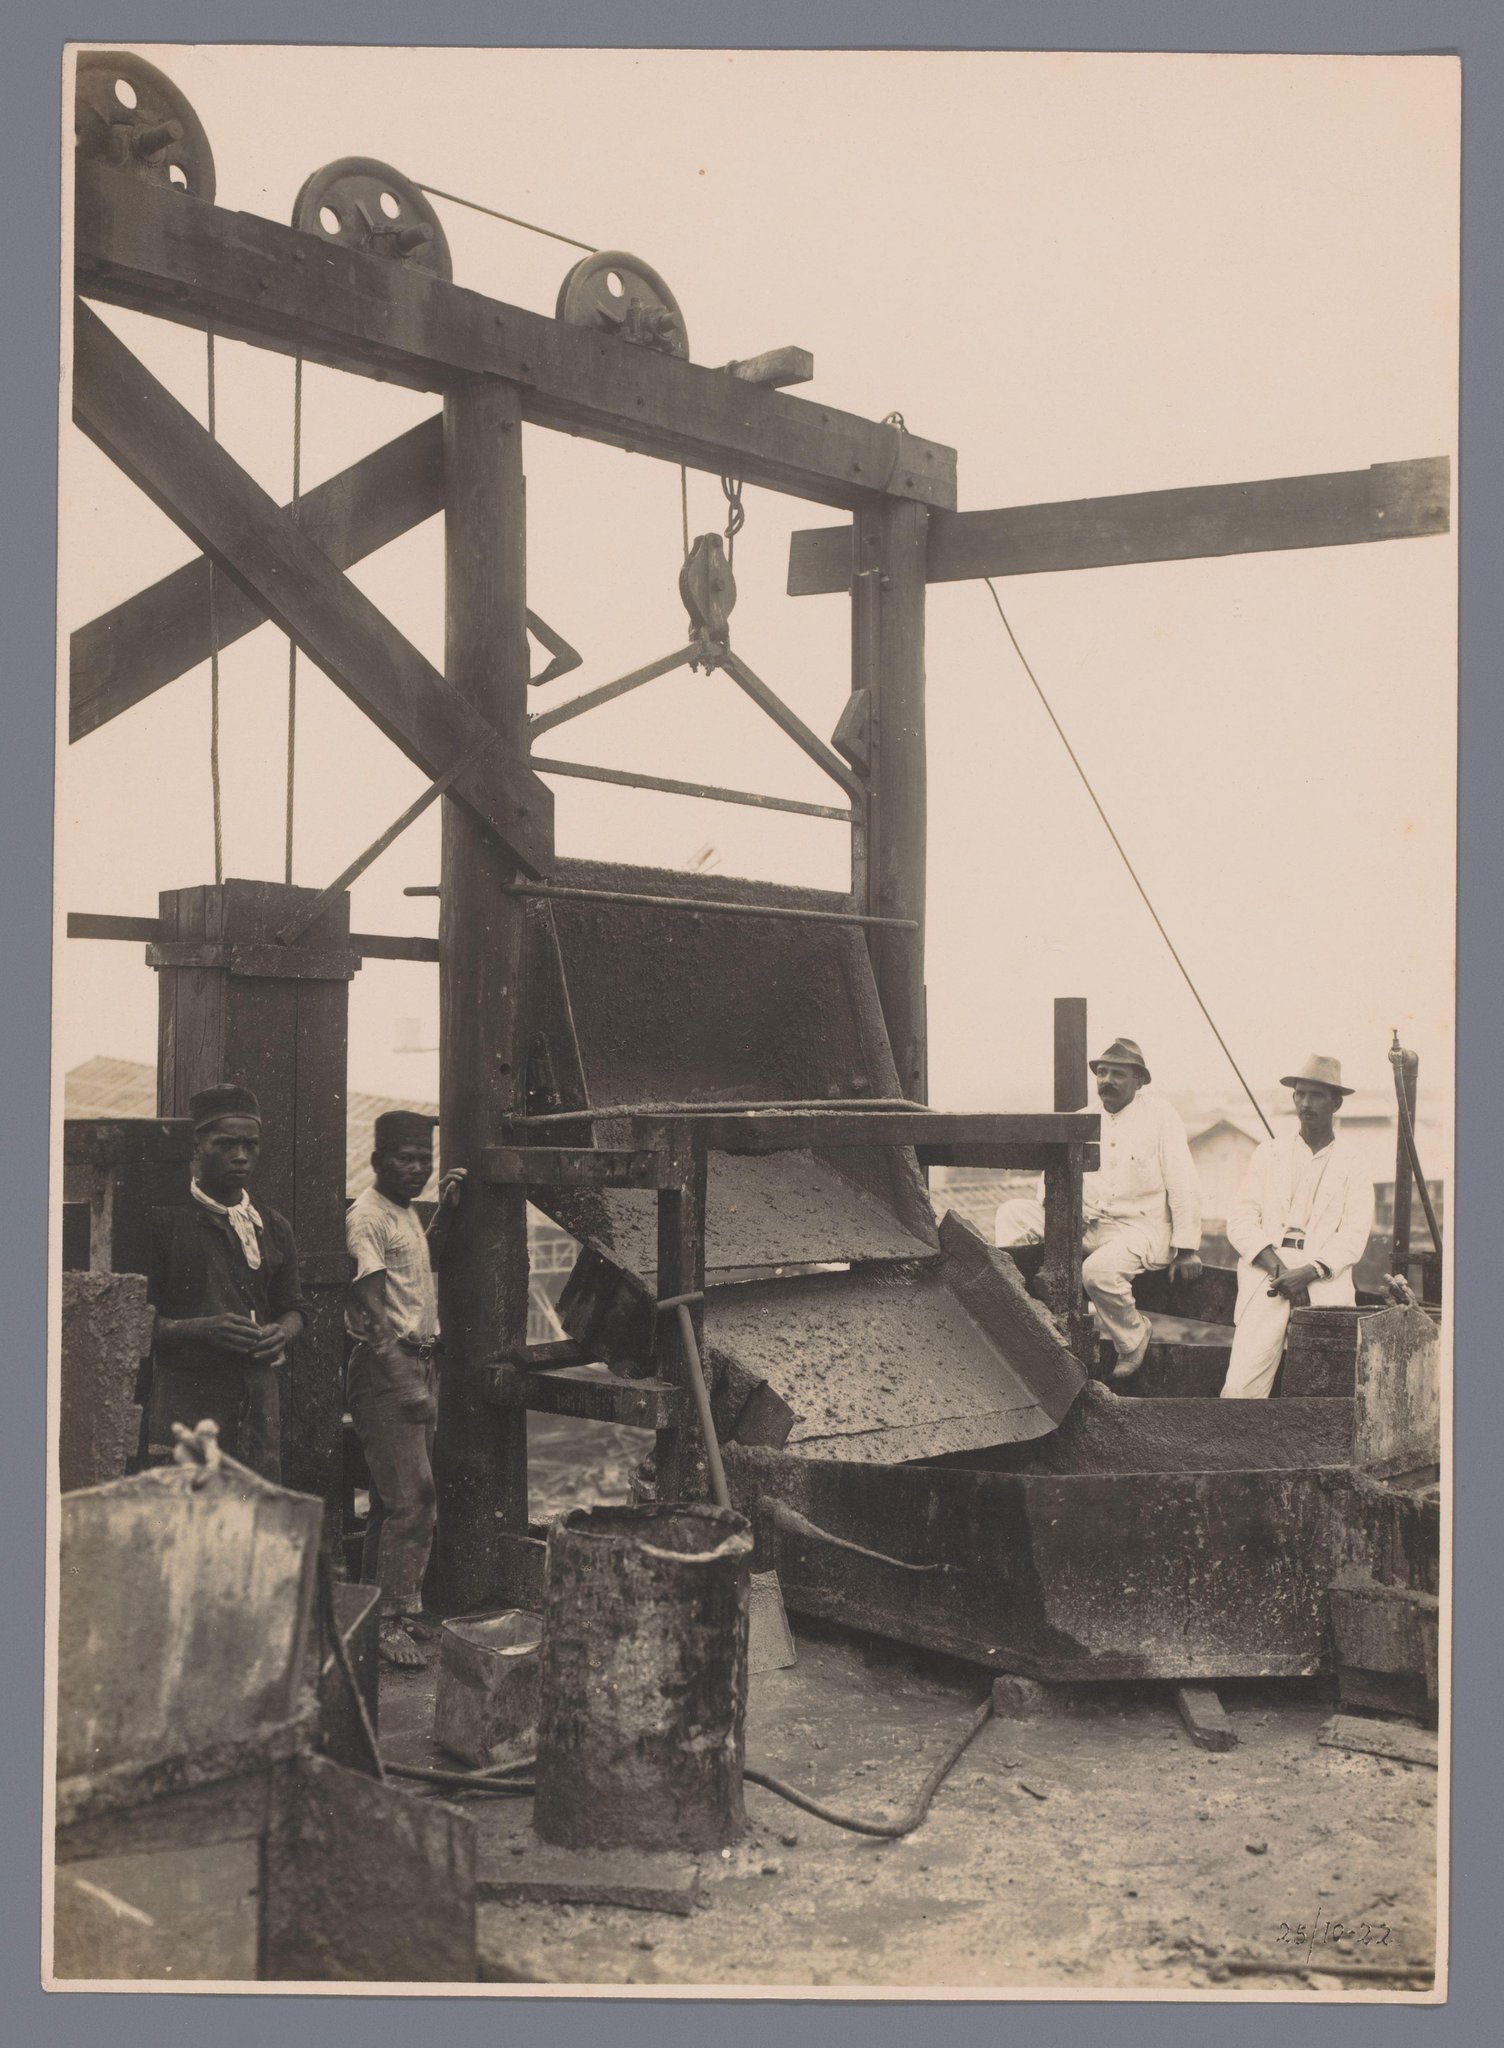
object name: photograph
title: Oceaanhaven Belawan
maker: Anonymous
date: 1922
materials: photographic support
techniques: gelatin silver print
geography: belawan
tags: making the overground structures (~ building activities), building-site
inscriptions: annotation: ‘No. 269 Bovenop de stortsteiger’, date: ‘25/10-22’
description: Stellage waarmee het beton gestort wordt, met arbeiders en opzichters. Genummerd: 269. Onderdeel van de groep van losse foto's over de aanleg van de haven Belawan aan de kust voor Medan, Sumatra 1921-1922.